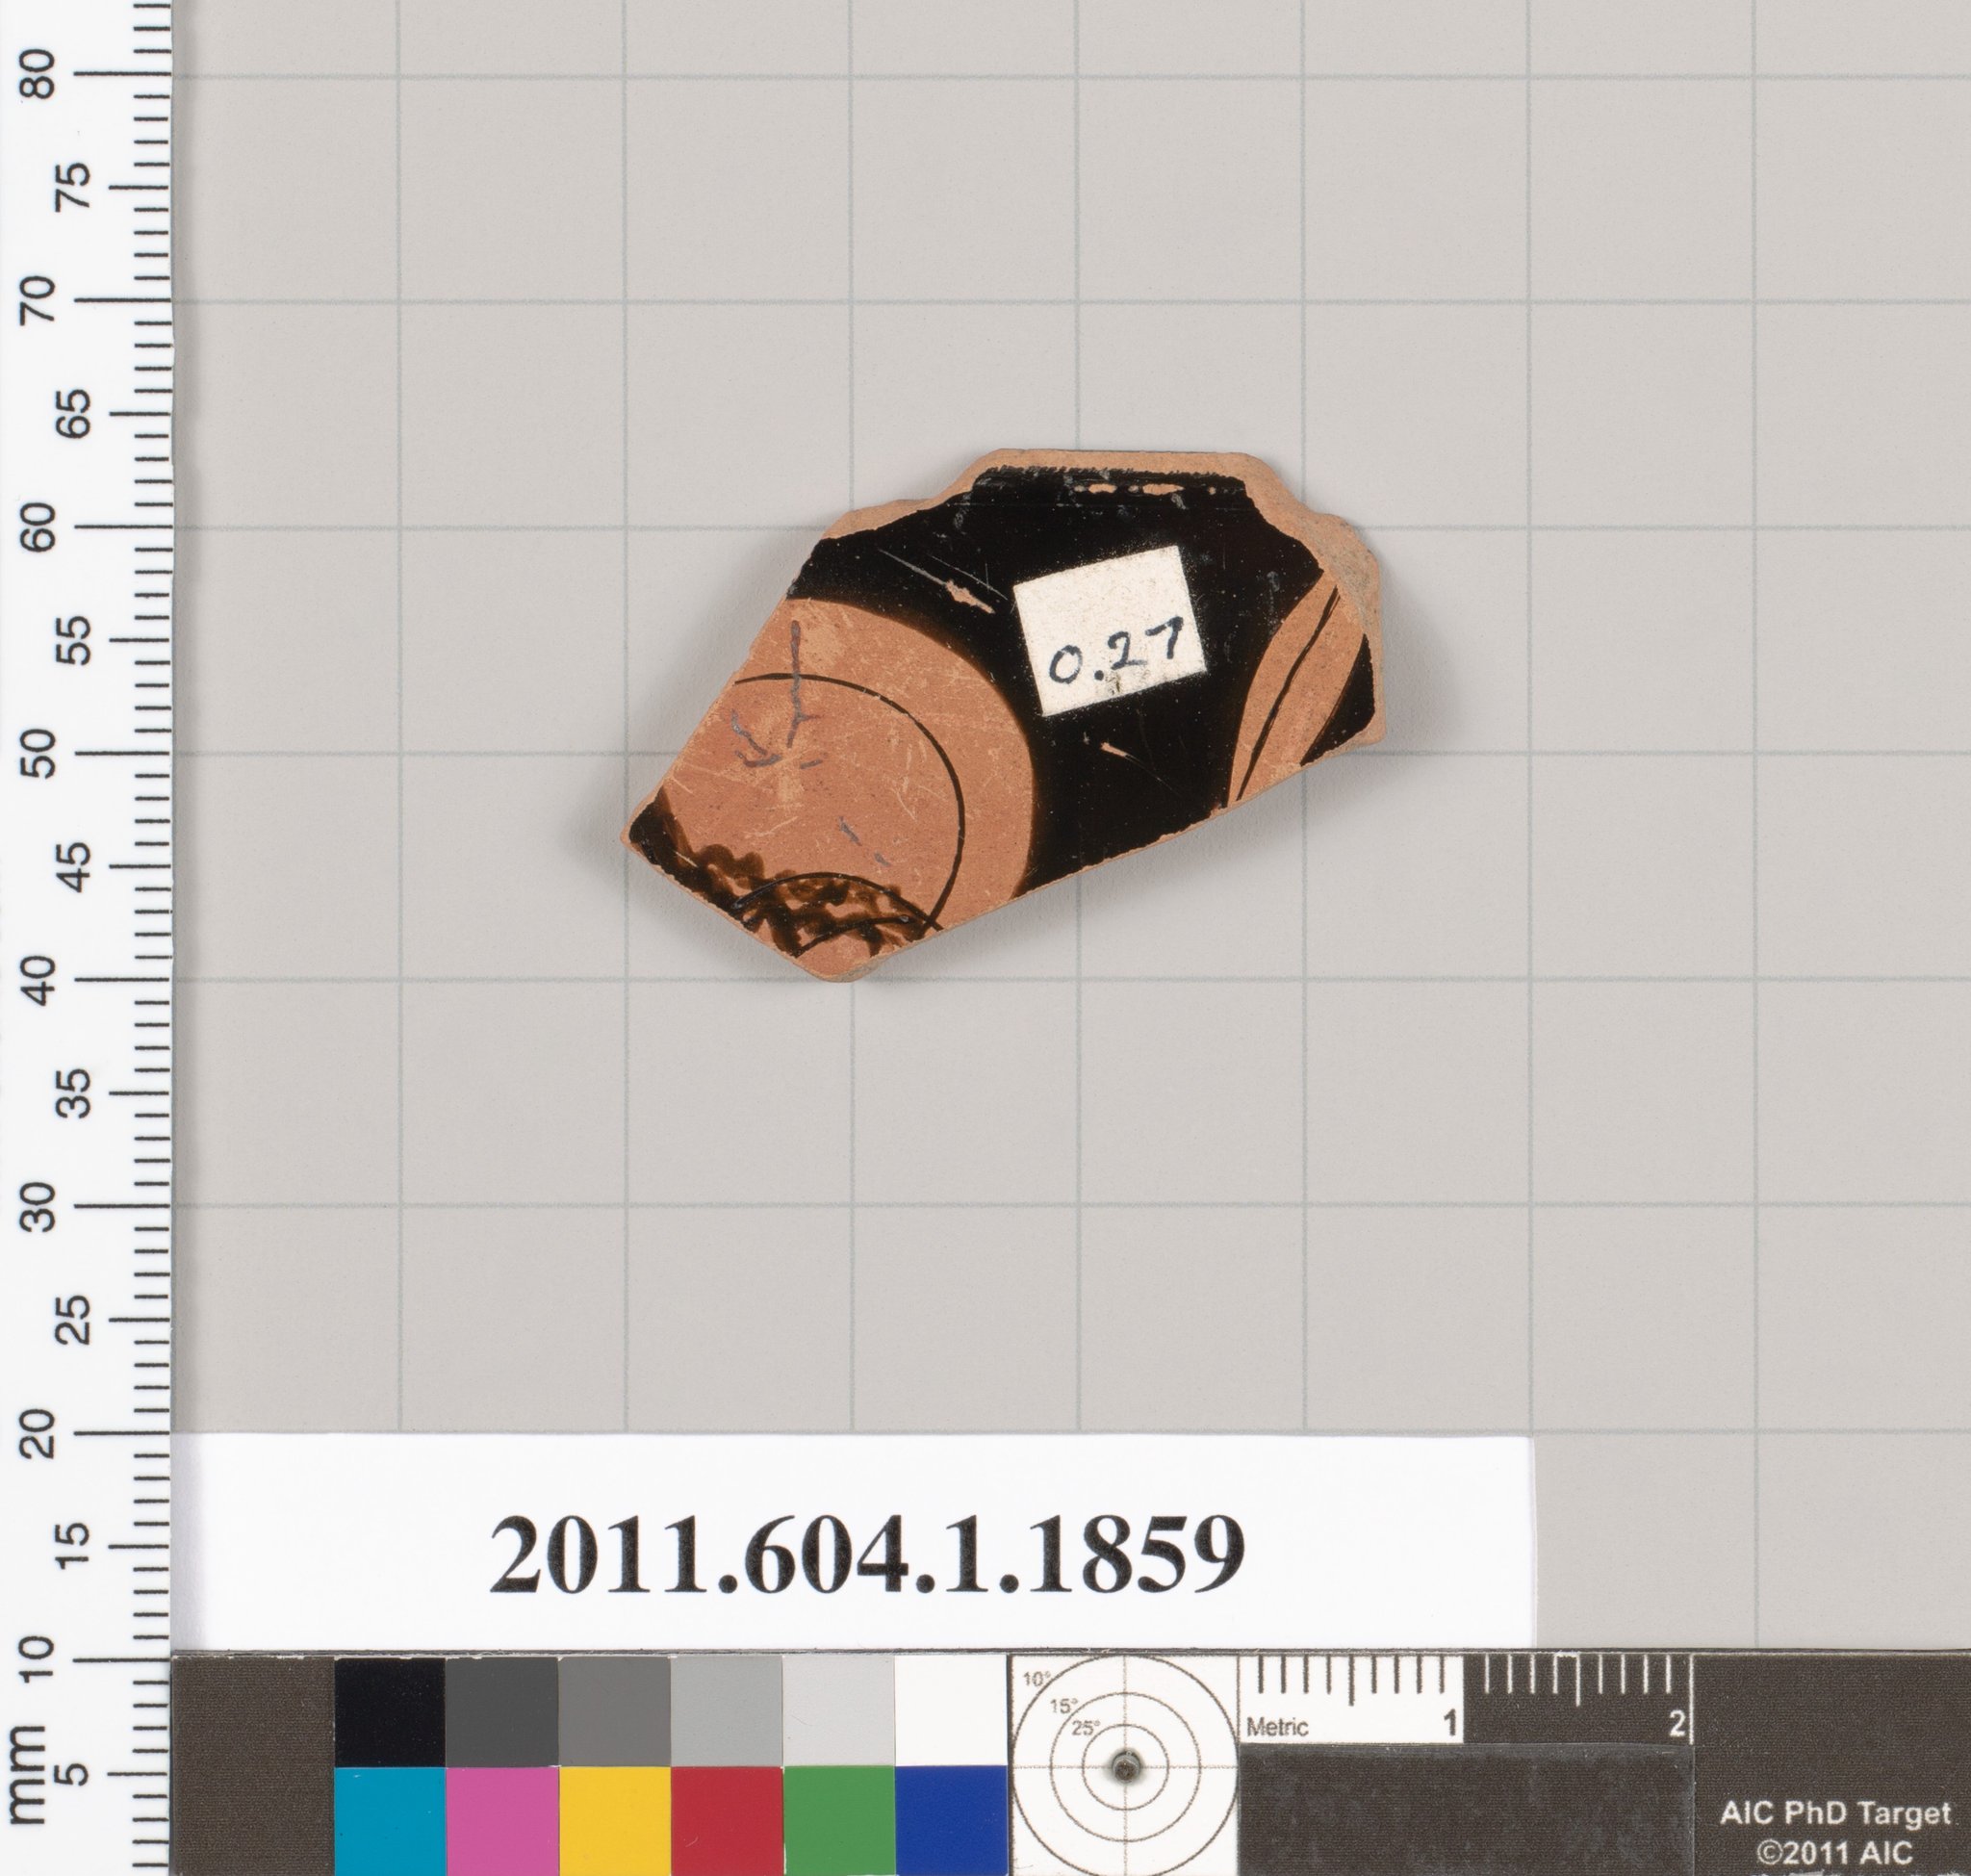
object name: kylix fragment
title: Terracotta rim fragment of a kylix (drinking cup)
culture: greek, attic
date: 460-450 BCE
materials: terracotta